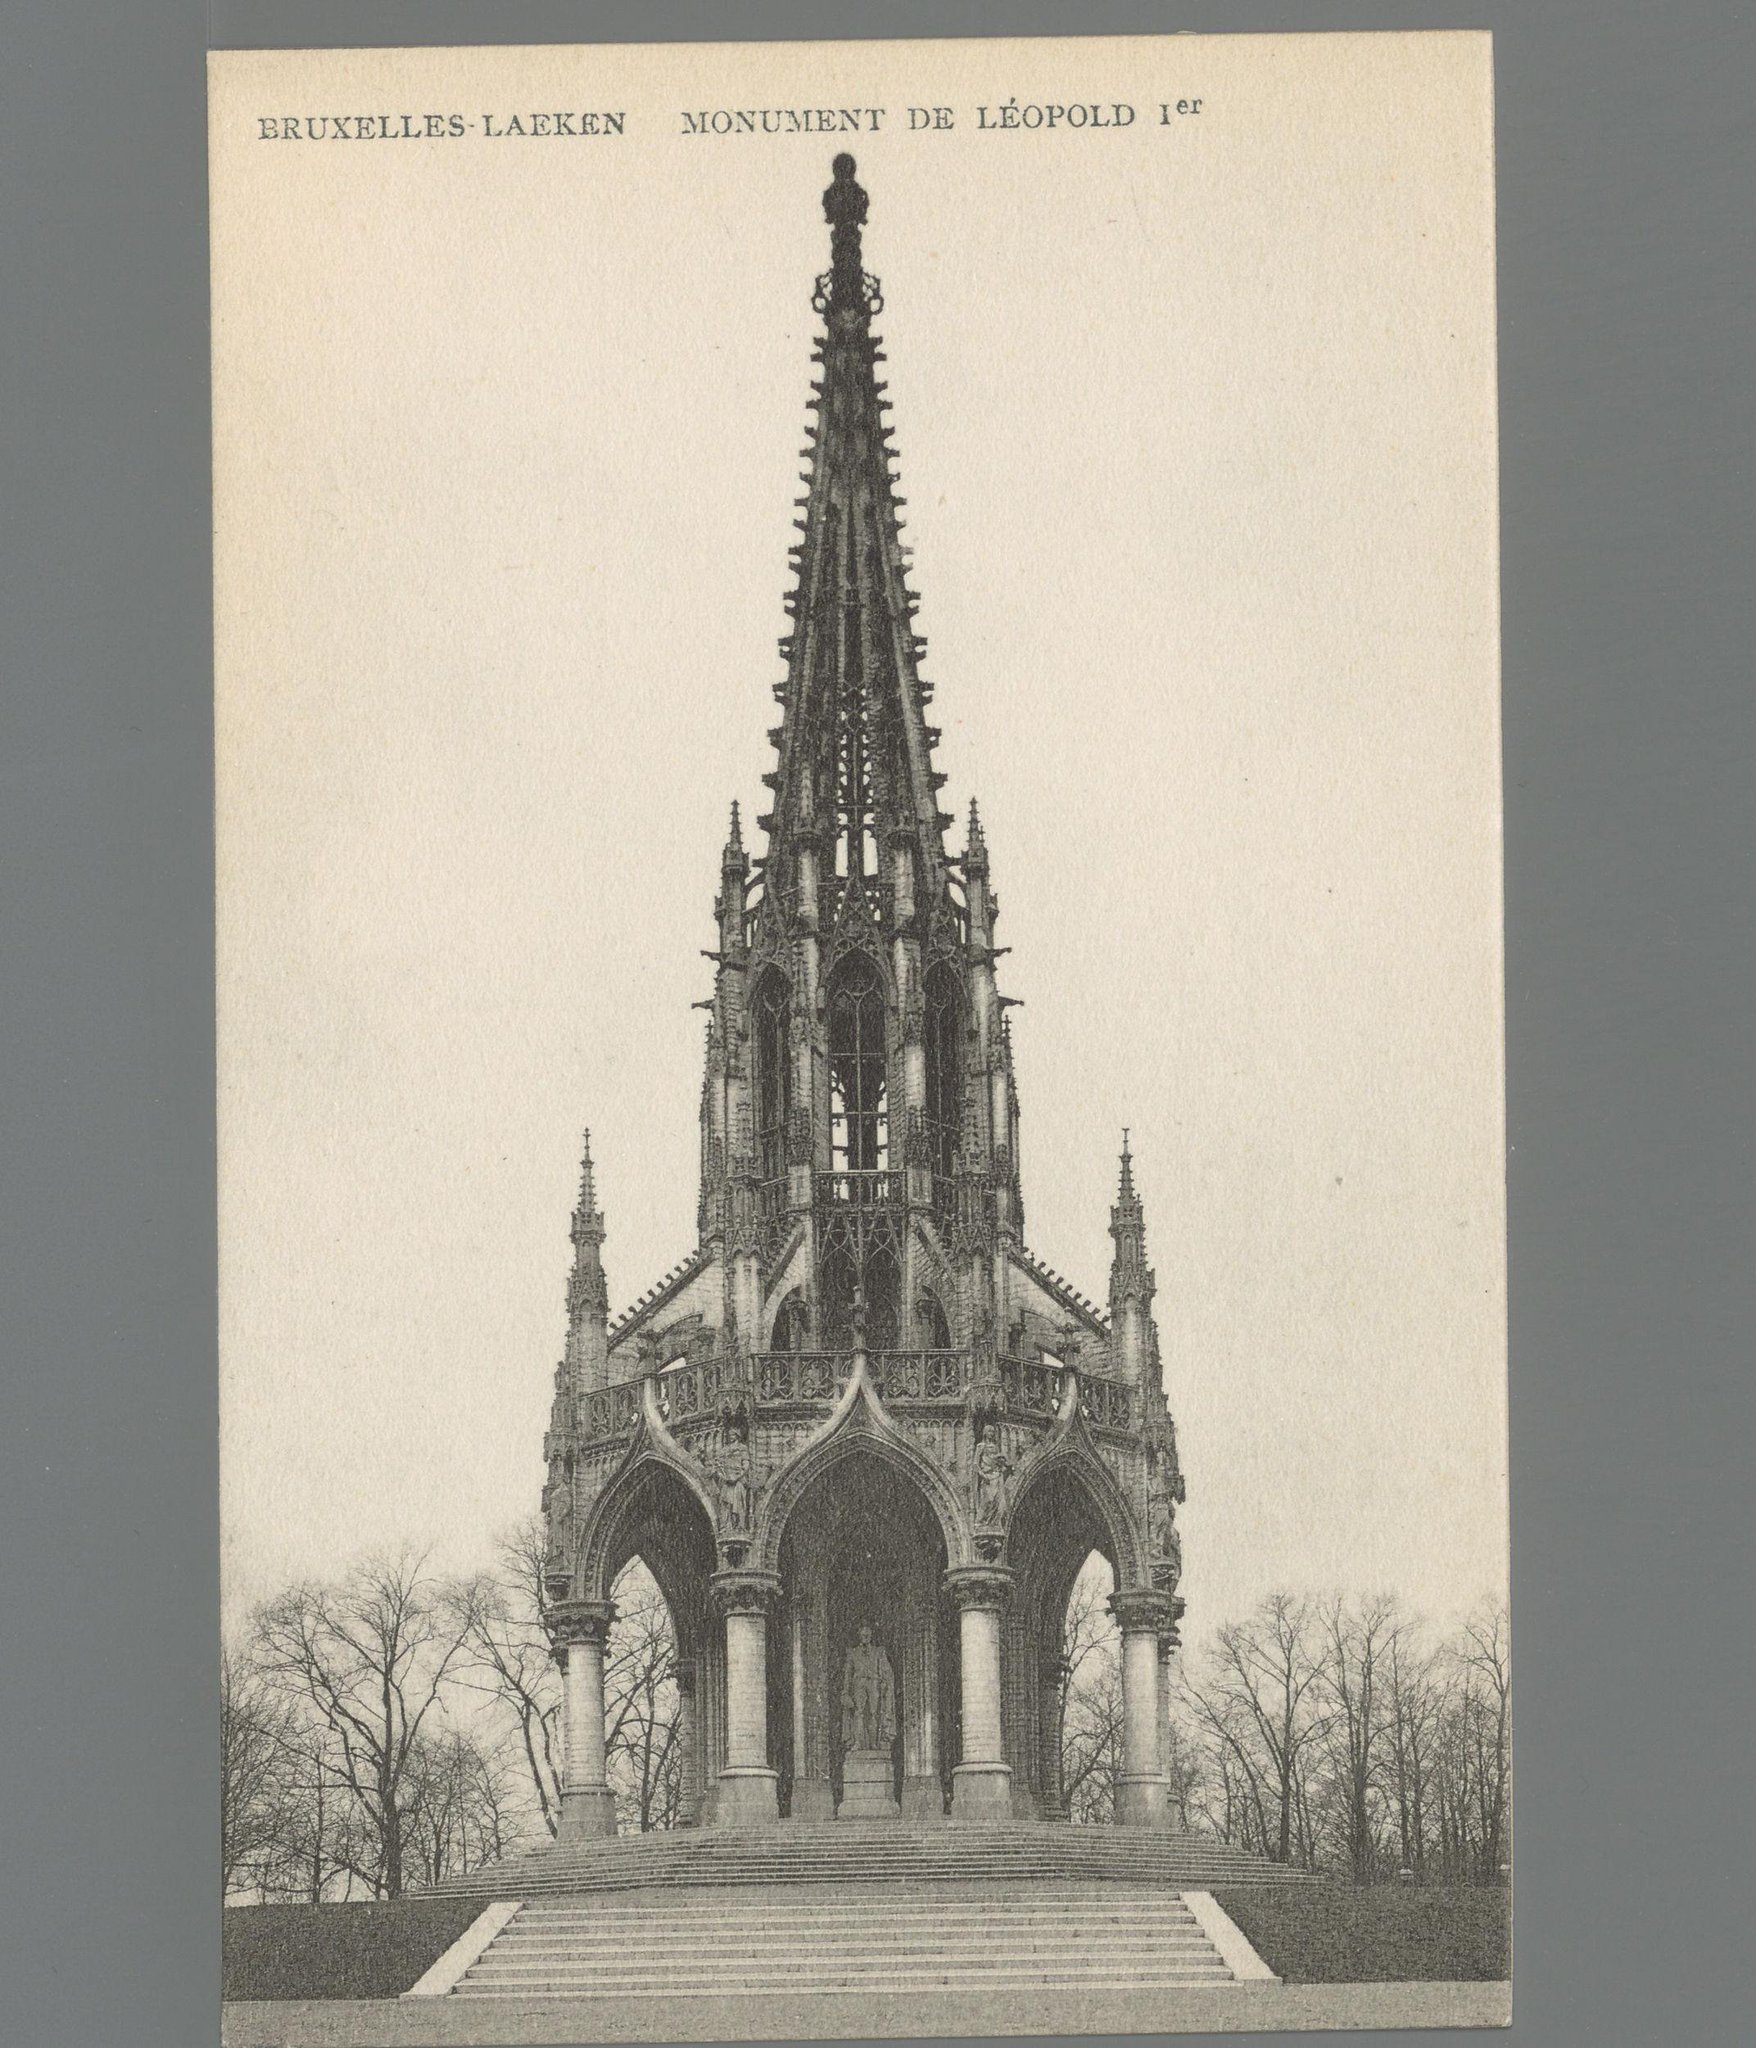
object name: photomechanical print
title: Bruxelles-Laeken. Monument de Léopold 1er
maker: Anonymous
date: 1906-1930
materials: cardboard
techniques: photograph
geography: brussels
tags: monument, statue, public gardens, park, laeken